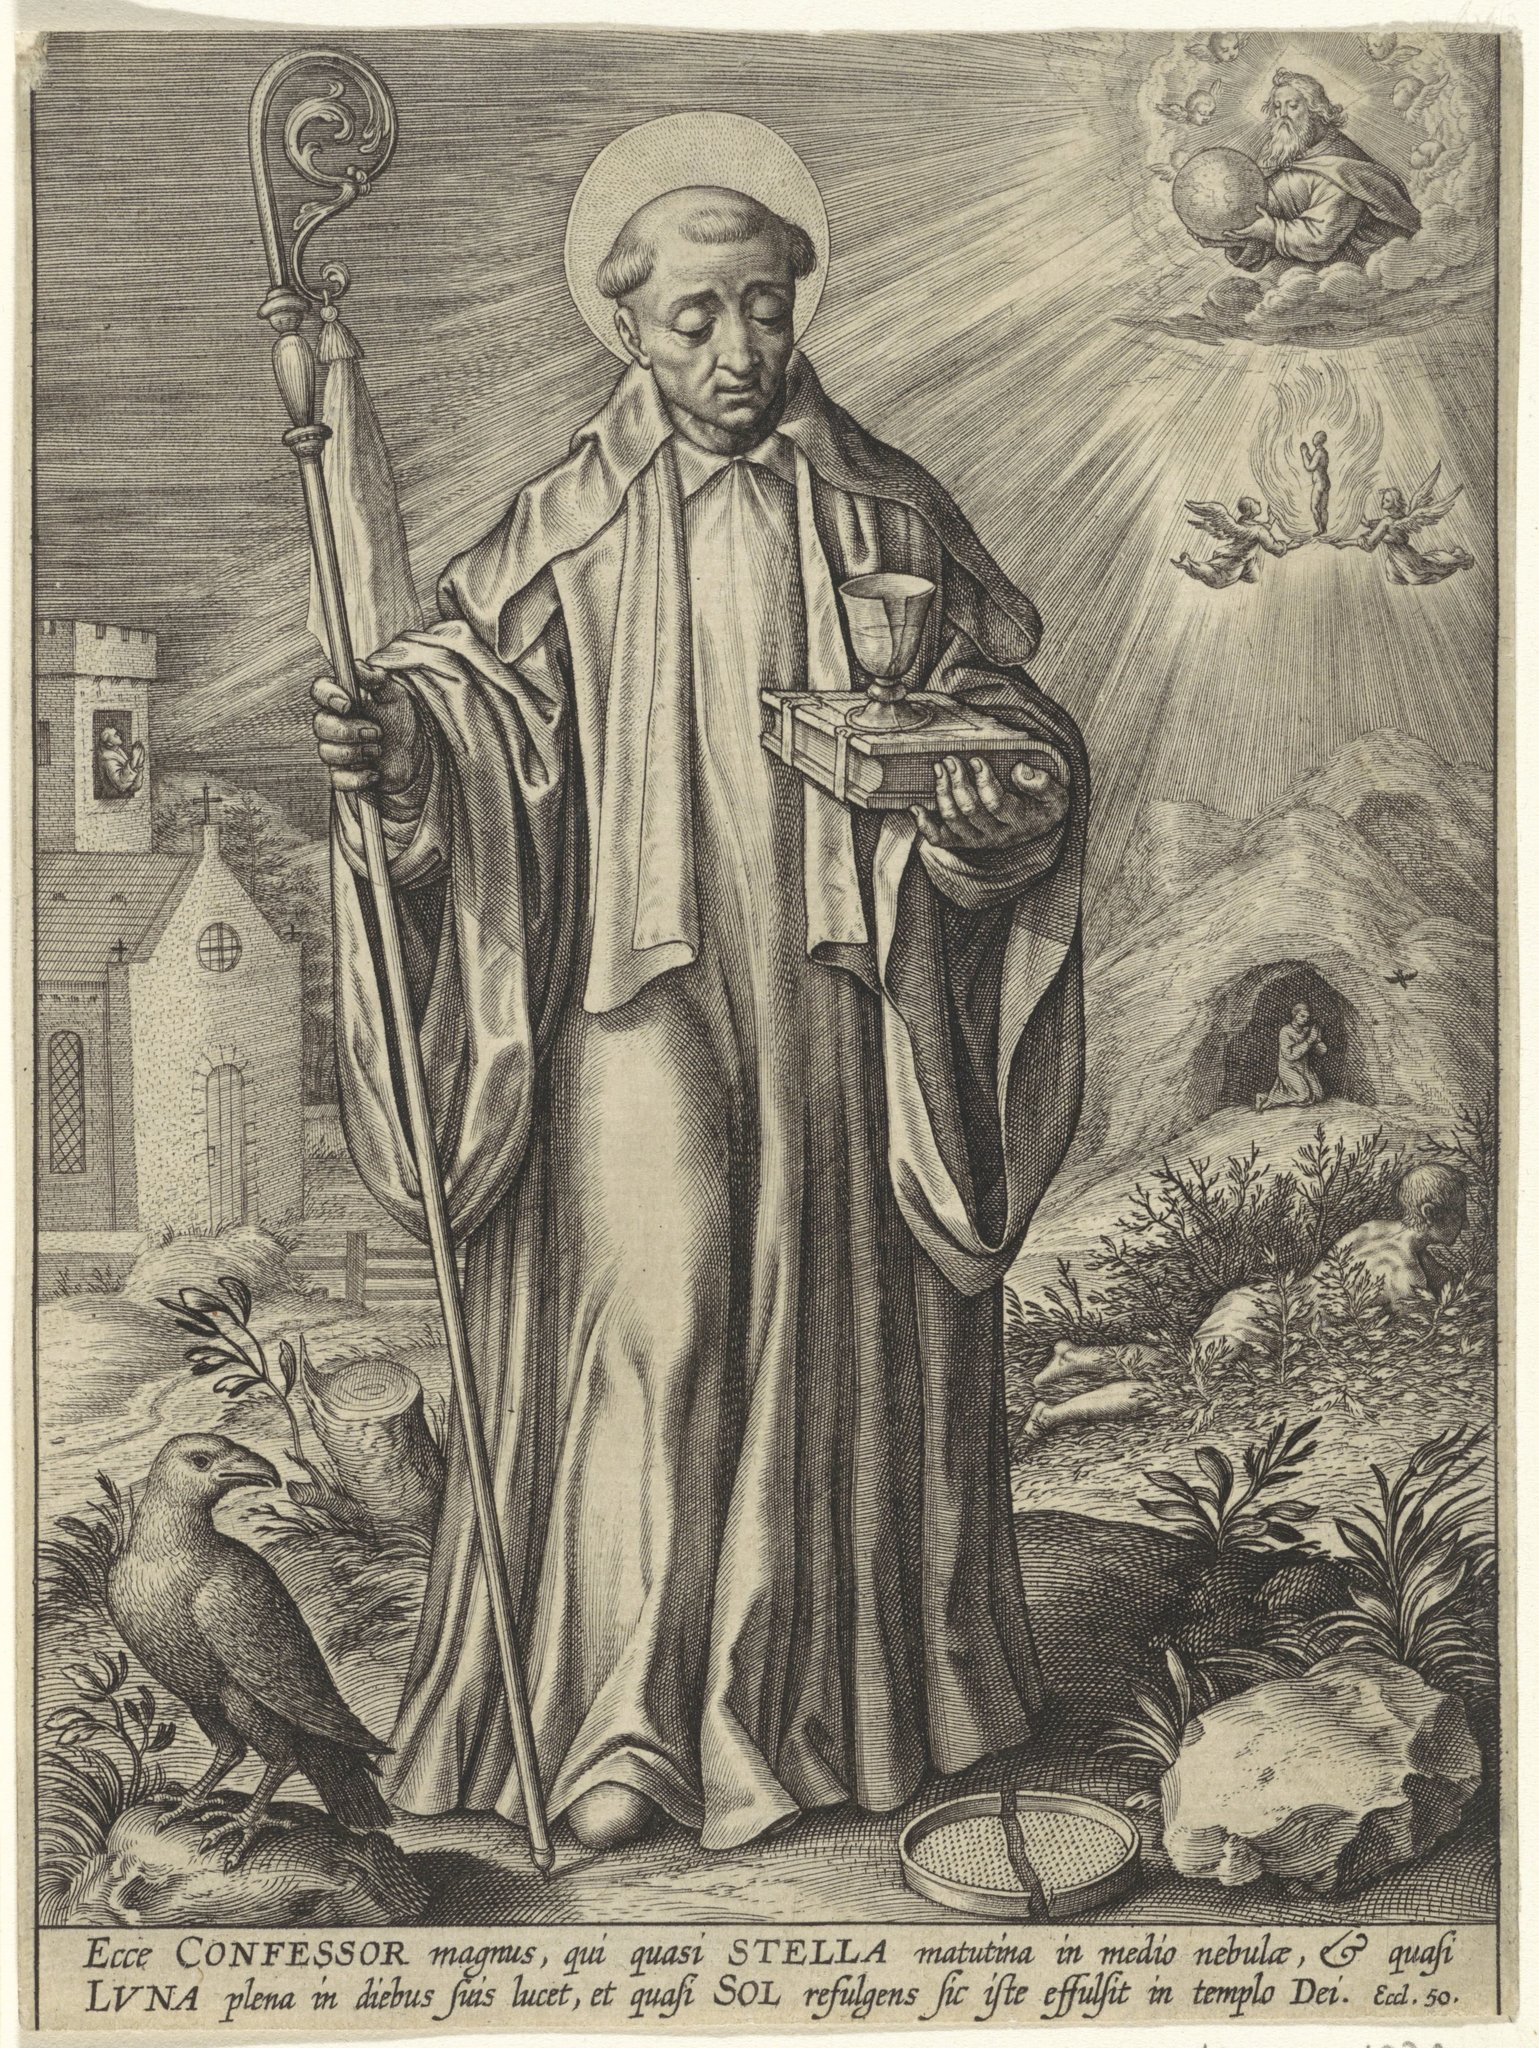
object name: print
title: H. Benedictus van Nursia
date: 1563-1619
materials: paper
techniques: engraving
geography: antwerp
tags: benedict of nurcia, abbot of monte cassino and founder of the benedictine order; possible attributes: aspergillum, book, cup (sometimes broken), raven with loaf, sieve (or tray), st. benedict throws himself naked into a thorn-bush to overcome temptations of the flesh (by naked women), visions of st. benedict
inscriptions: collector's mark: Lugt 2228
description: Landschap met de heilige Benedictus, in het habijt van zijn orde. In zijn ene hand houdt hij de staf met de wijwaterkwast (die werd gebruikt voor het ritueel van duivelbanning), in zijn andere hand een Bijbel met een kelk, een verwijzing naar een poging hem te vergiftigen. Aan zijn voeten de gebroken zeef, die verwijst naar zijn verzorgster Cyrilla die hem vergezelde op zijn reis naar Rome. Toen zij een zeef brak werd die door Benedictus op wonderbaarlijke wijze hersteld. Links zit de raaf, die verwijst naar de poging van een afgunstige priester om Benedictus met brood te vergiftigen. Op de achtergrond scènes uit zijn leven. Rechts ligt hij naakt in een doornstruik om van zijn vleselijke verlangens verlost te worden. Verder naar de achtergrond is te zien hoe hij de raaf die hem het vergiftigde brood komt brengen weer terugstuurt. Links op de achtergrond Benedictus in het klooster van Monte Cassino. Hij heeft een visioen van God de Vader en van zijn ziel die door engelen naar de hemel wordt gedragen. In de marge een tweeregelig Bijbelcitaat uit Sir. 50 in het Latijn.